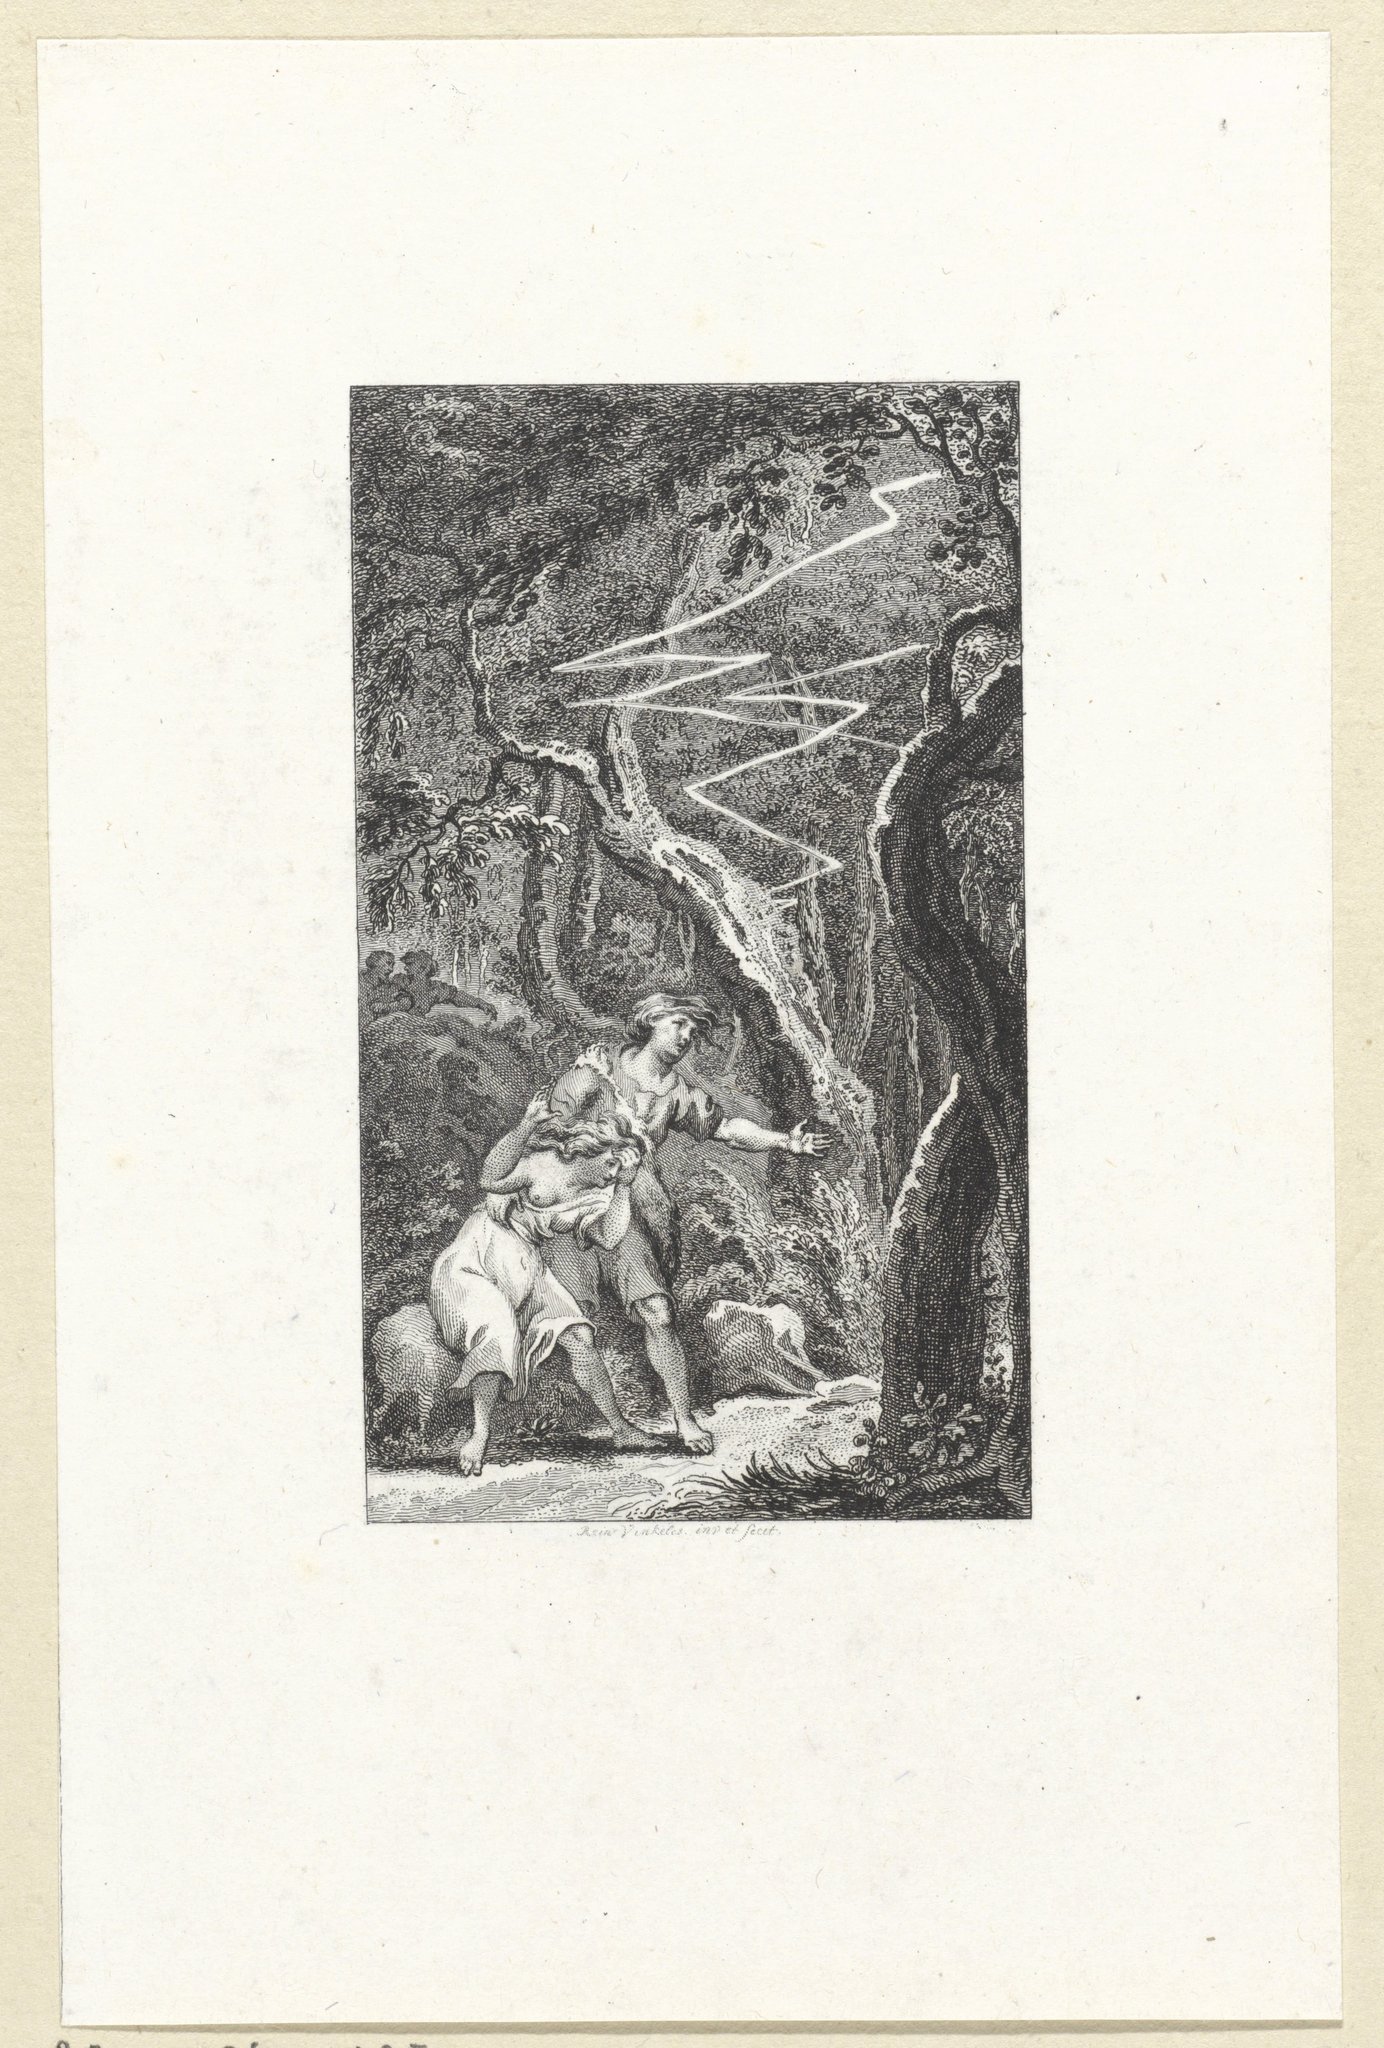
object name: print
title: Paulus en Virginia in een bos bij onweer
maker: reinier vinkeles (i)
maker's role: draughtsman, print maker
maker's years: 1741-1816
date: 1751-1816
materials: paper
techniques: engraving, etching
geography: amsterdam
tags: forest, wood, lightning, flash of lightning, thunderbolt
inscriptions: collector's mark: Lugt 2228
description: In een bos ontwijken Paulus en Virginia een bliksemschicht die vlak naast hen inslaat in een boom. Illustratie bij het verhaal 'Paul et Virginie', over de liefde tussen een blank meisje en een blanke jongen die begin 18e eeuw samen opgroeien in een Franse kolonie.